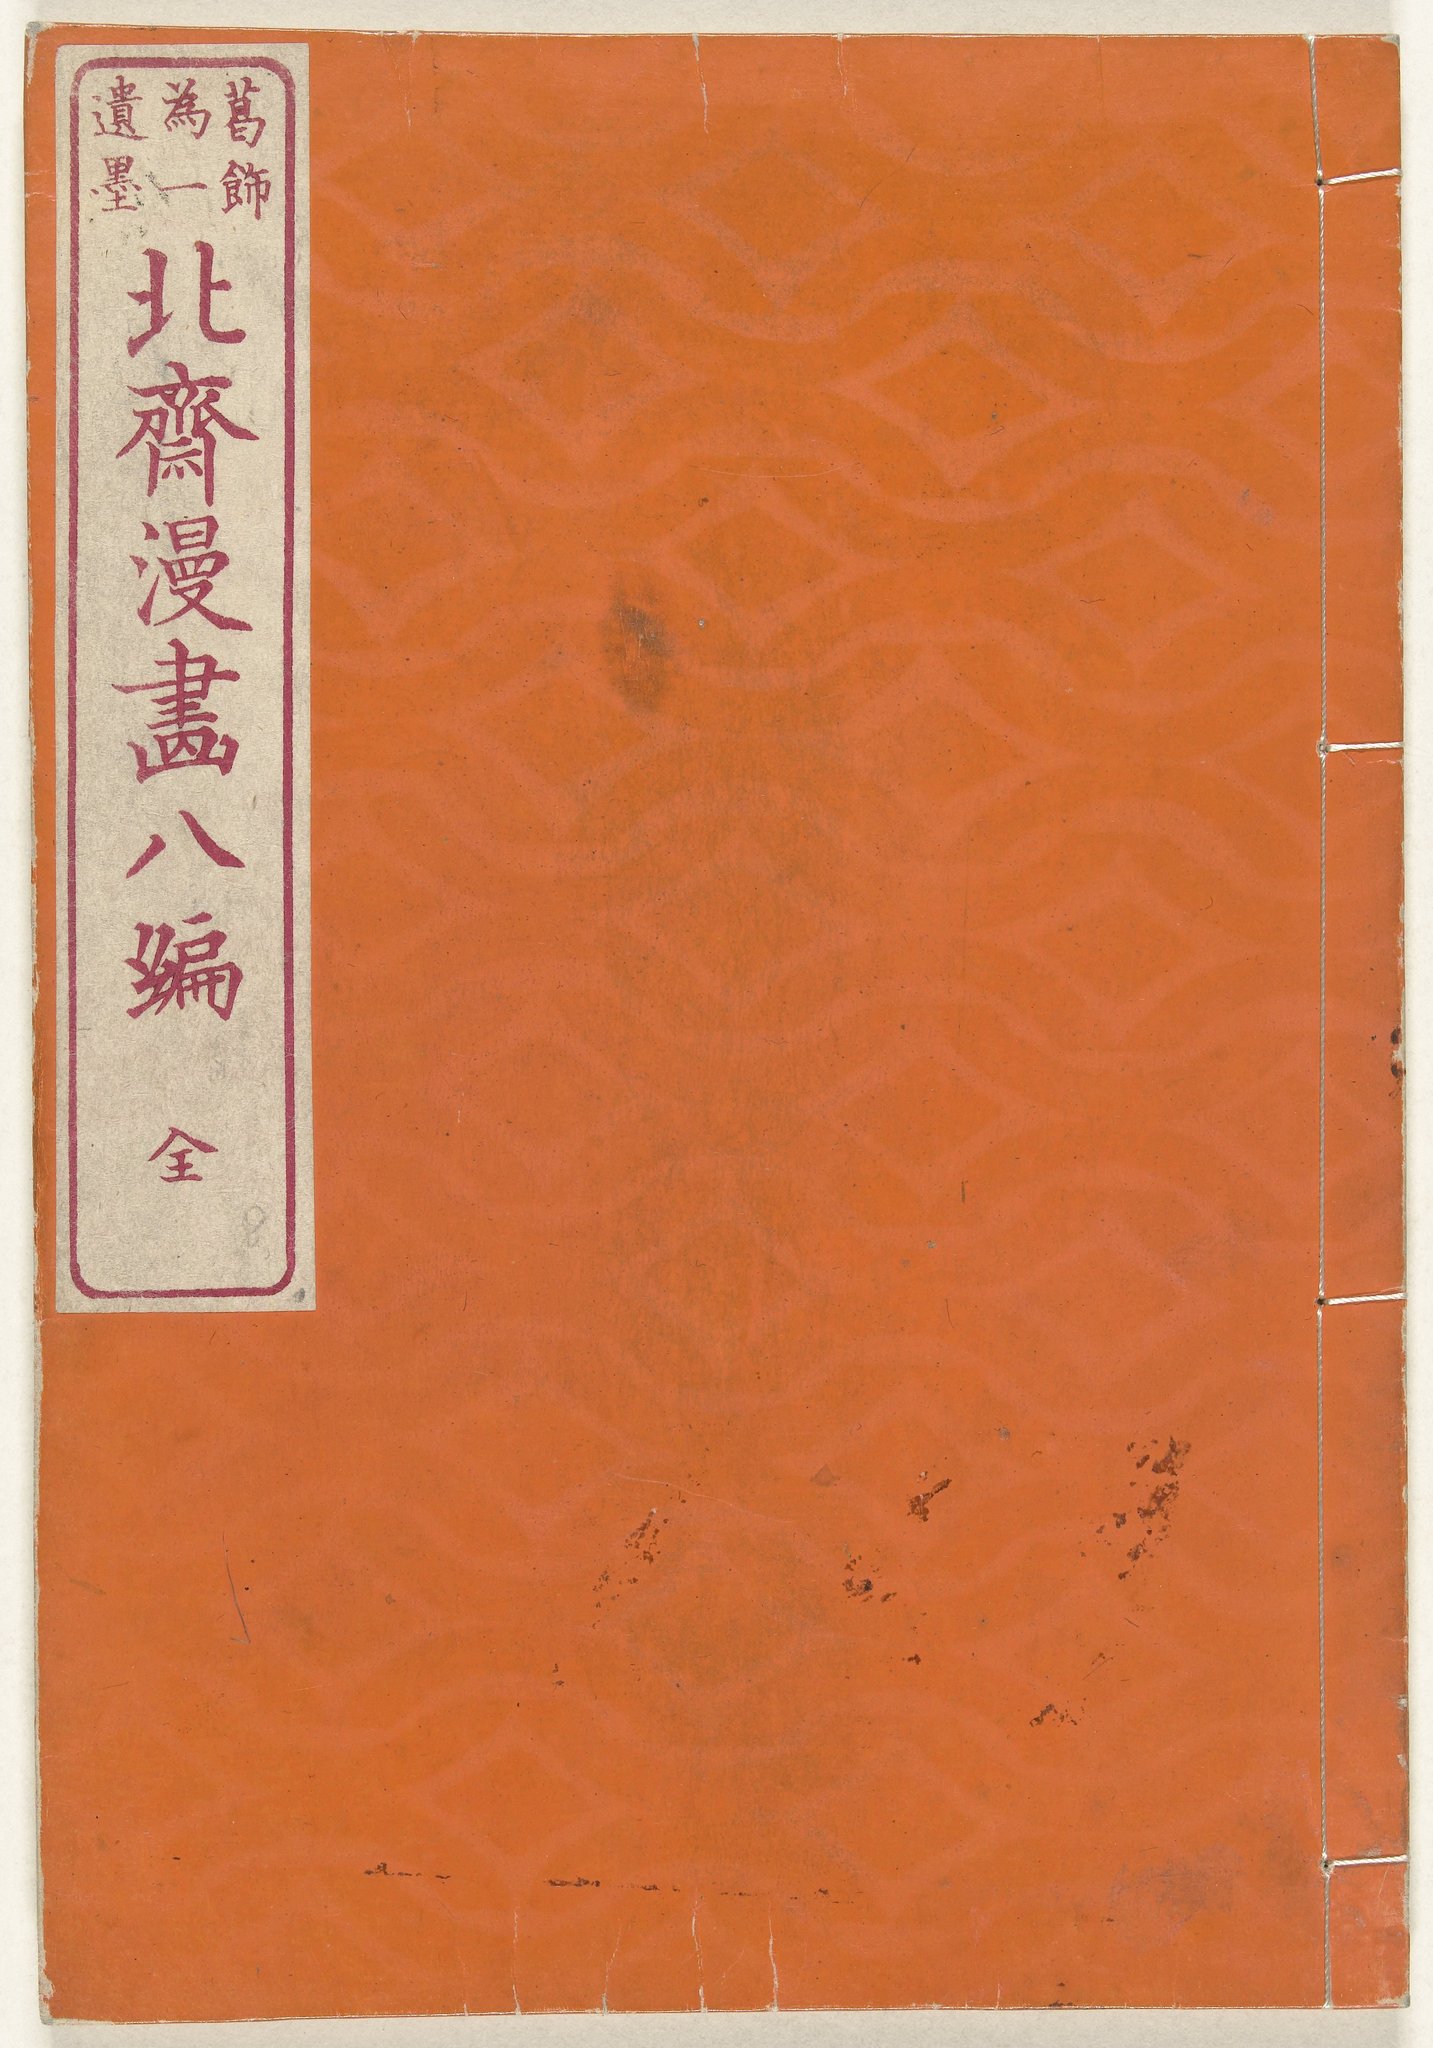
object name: book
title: Hokusai manga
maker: katsushika hokusai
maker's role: draughtsman, print maker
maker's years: 1760-1849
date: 1878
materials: paper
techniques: woodcut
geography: tokyo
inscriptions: collector's mark: ‘Rijksschool voor kunstnijverheid’ Lugt 3937, collector's mark: Lugt 2228